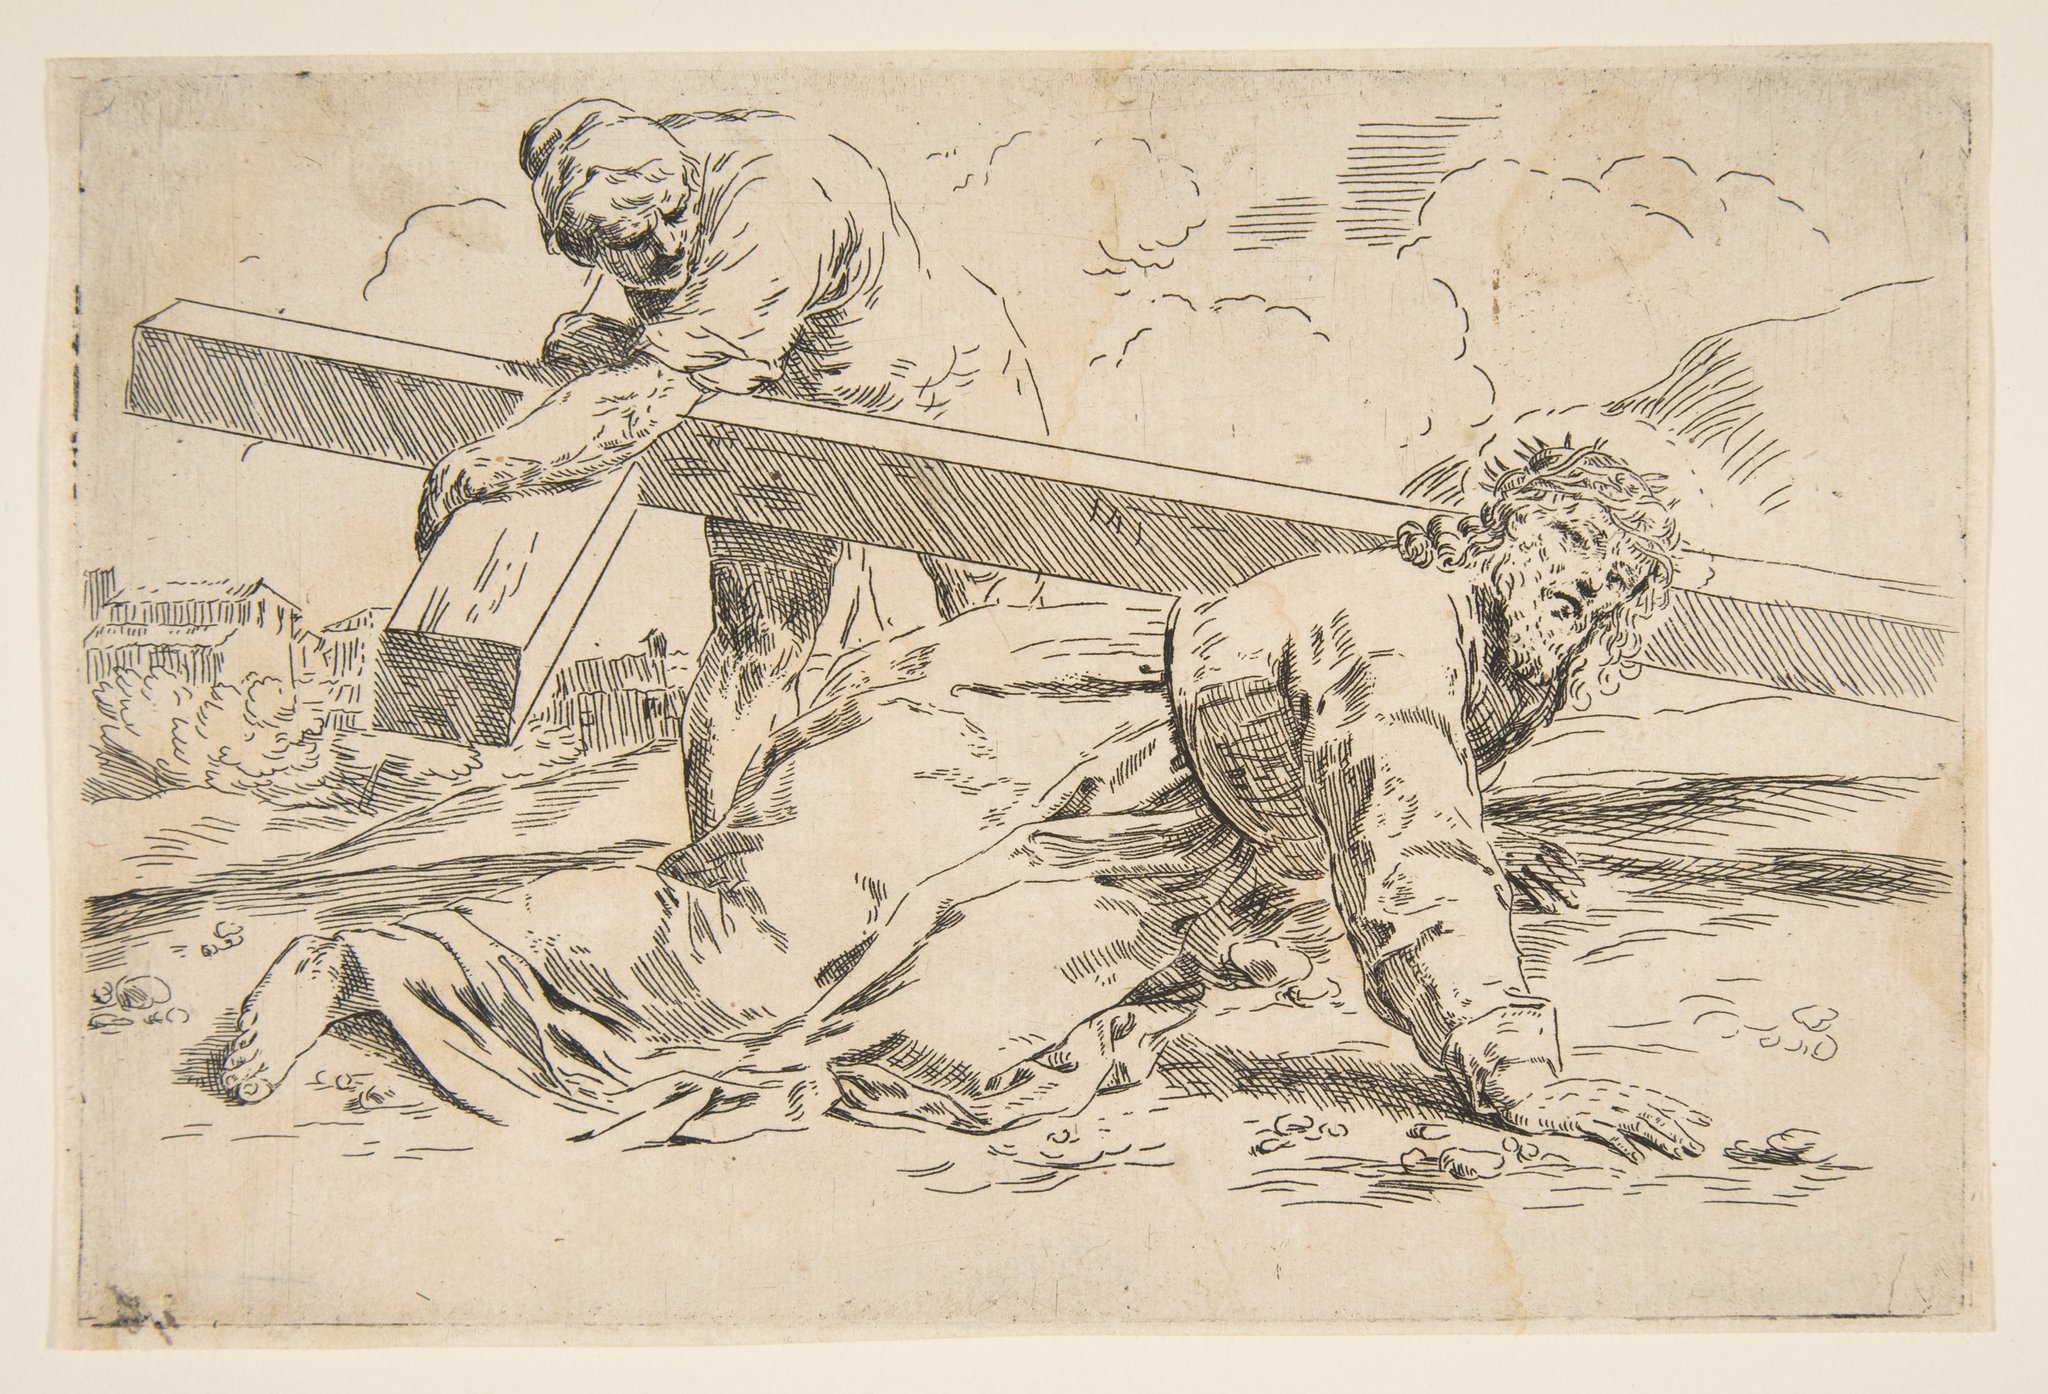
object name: print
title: Christ bearing the cross on his back, copy after Cantarini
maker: simone cantarini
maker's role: artist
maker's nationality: italian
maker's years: 1612-1648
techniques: etching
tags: men,christ,cross